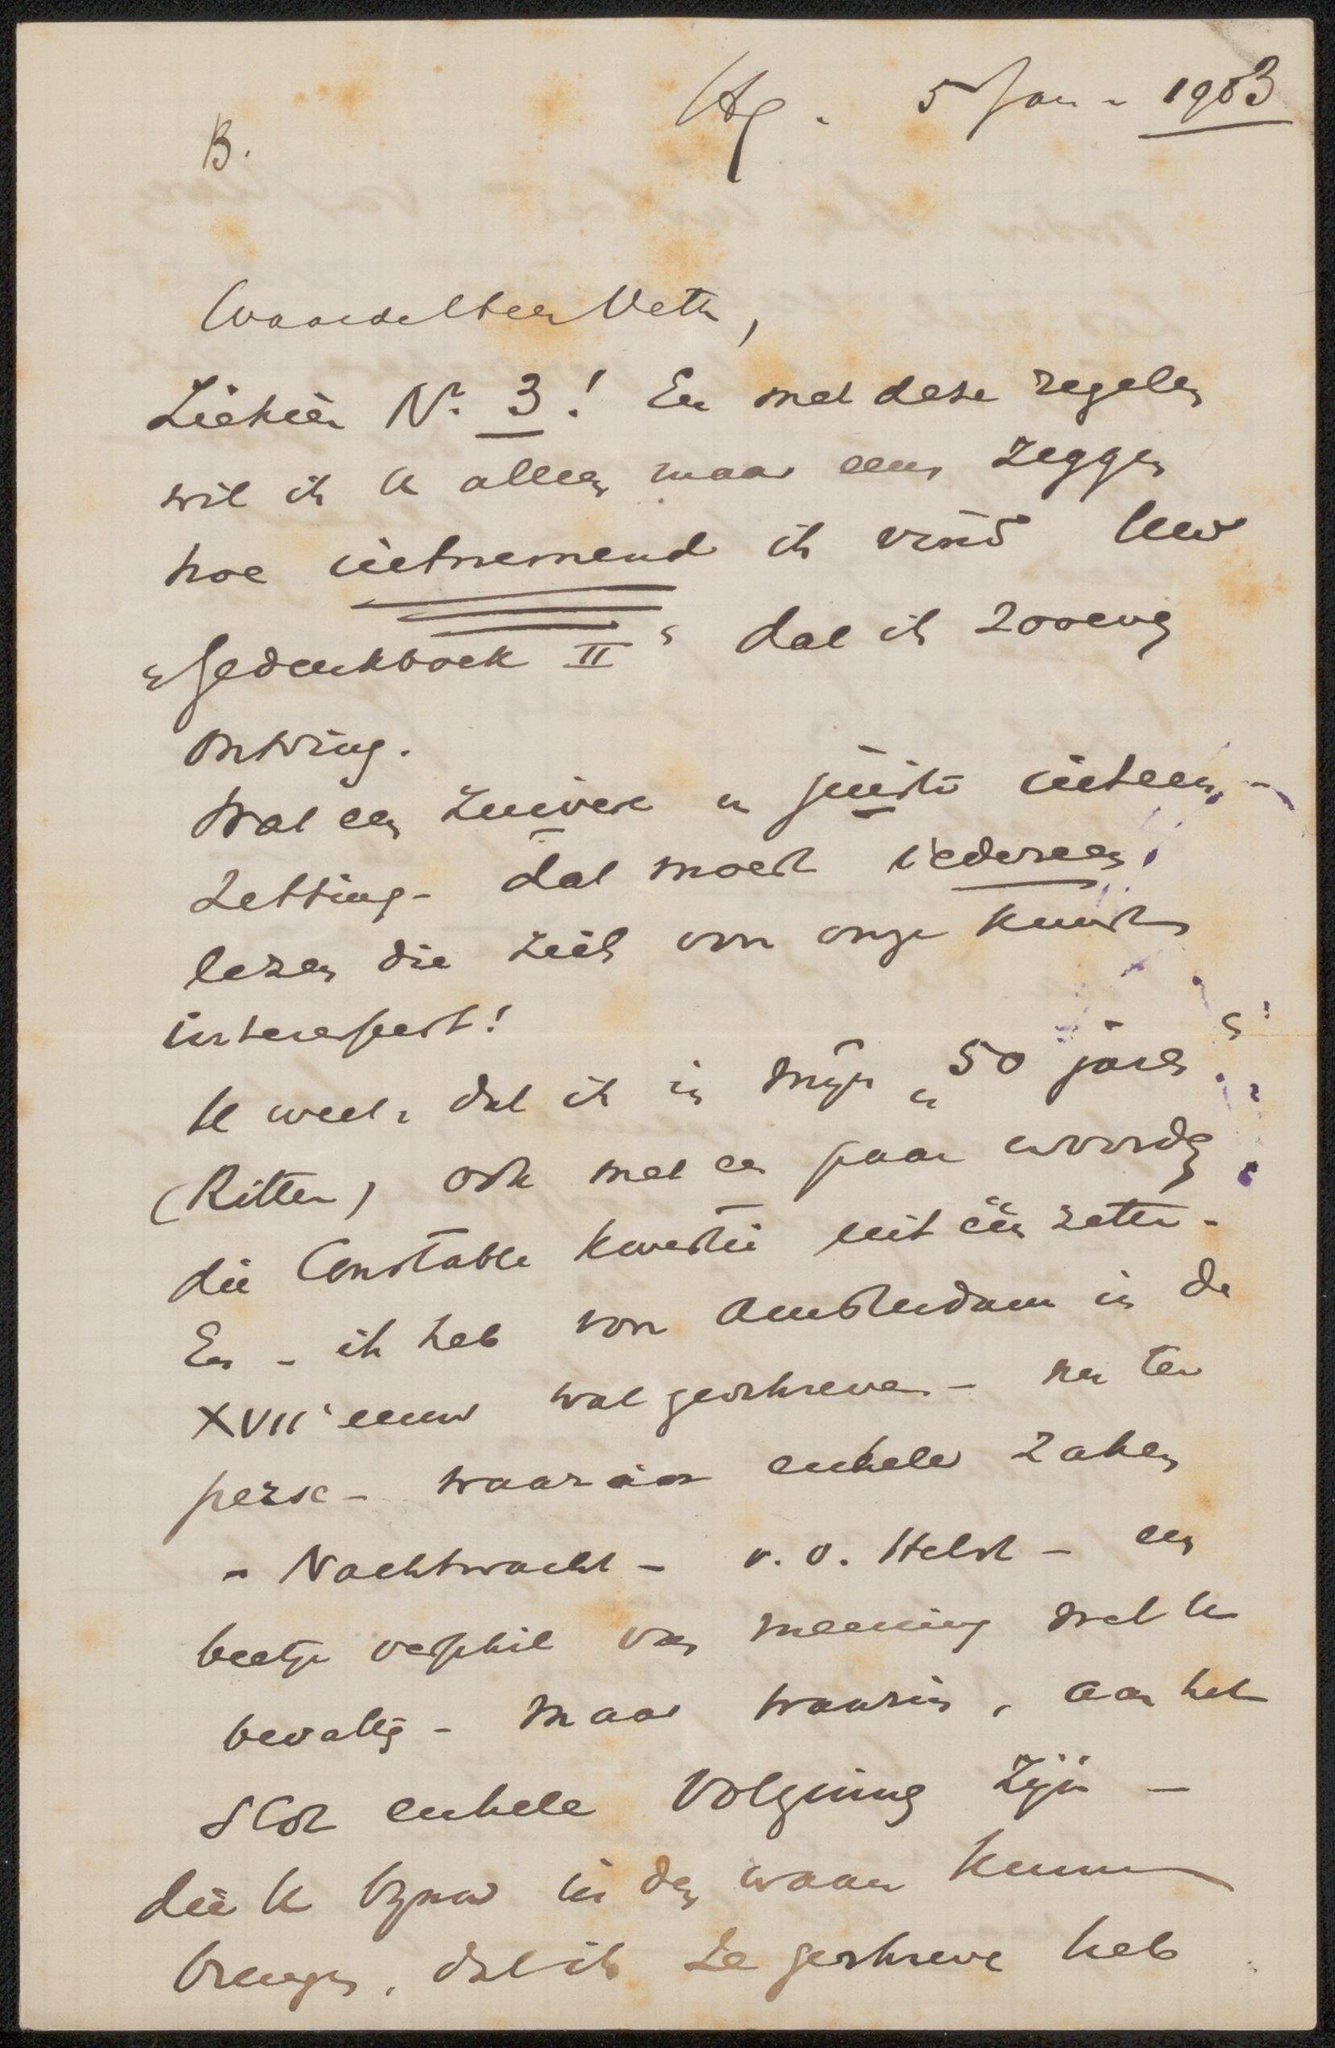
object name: letter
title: Brief aan Jan Veth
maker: abraham bredius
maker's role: kunsthistoricus, museumdirecteur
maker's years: 1855-1946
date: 1903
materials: ink, paper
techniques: pen, writing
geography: the hague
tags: the hague, jozef israëls, dordrecht, amsterdam, painter, print maker, draughtsman, designer, jan veth, wilhelm von bode, printed matter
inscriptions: collector's mark: ‘RPK’